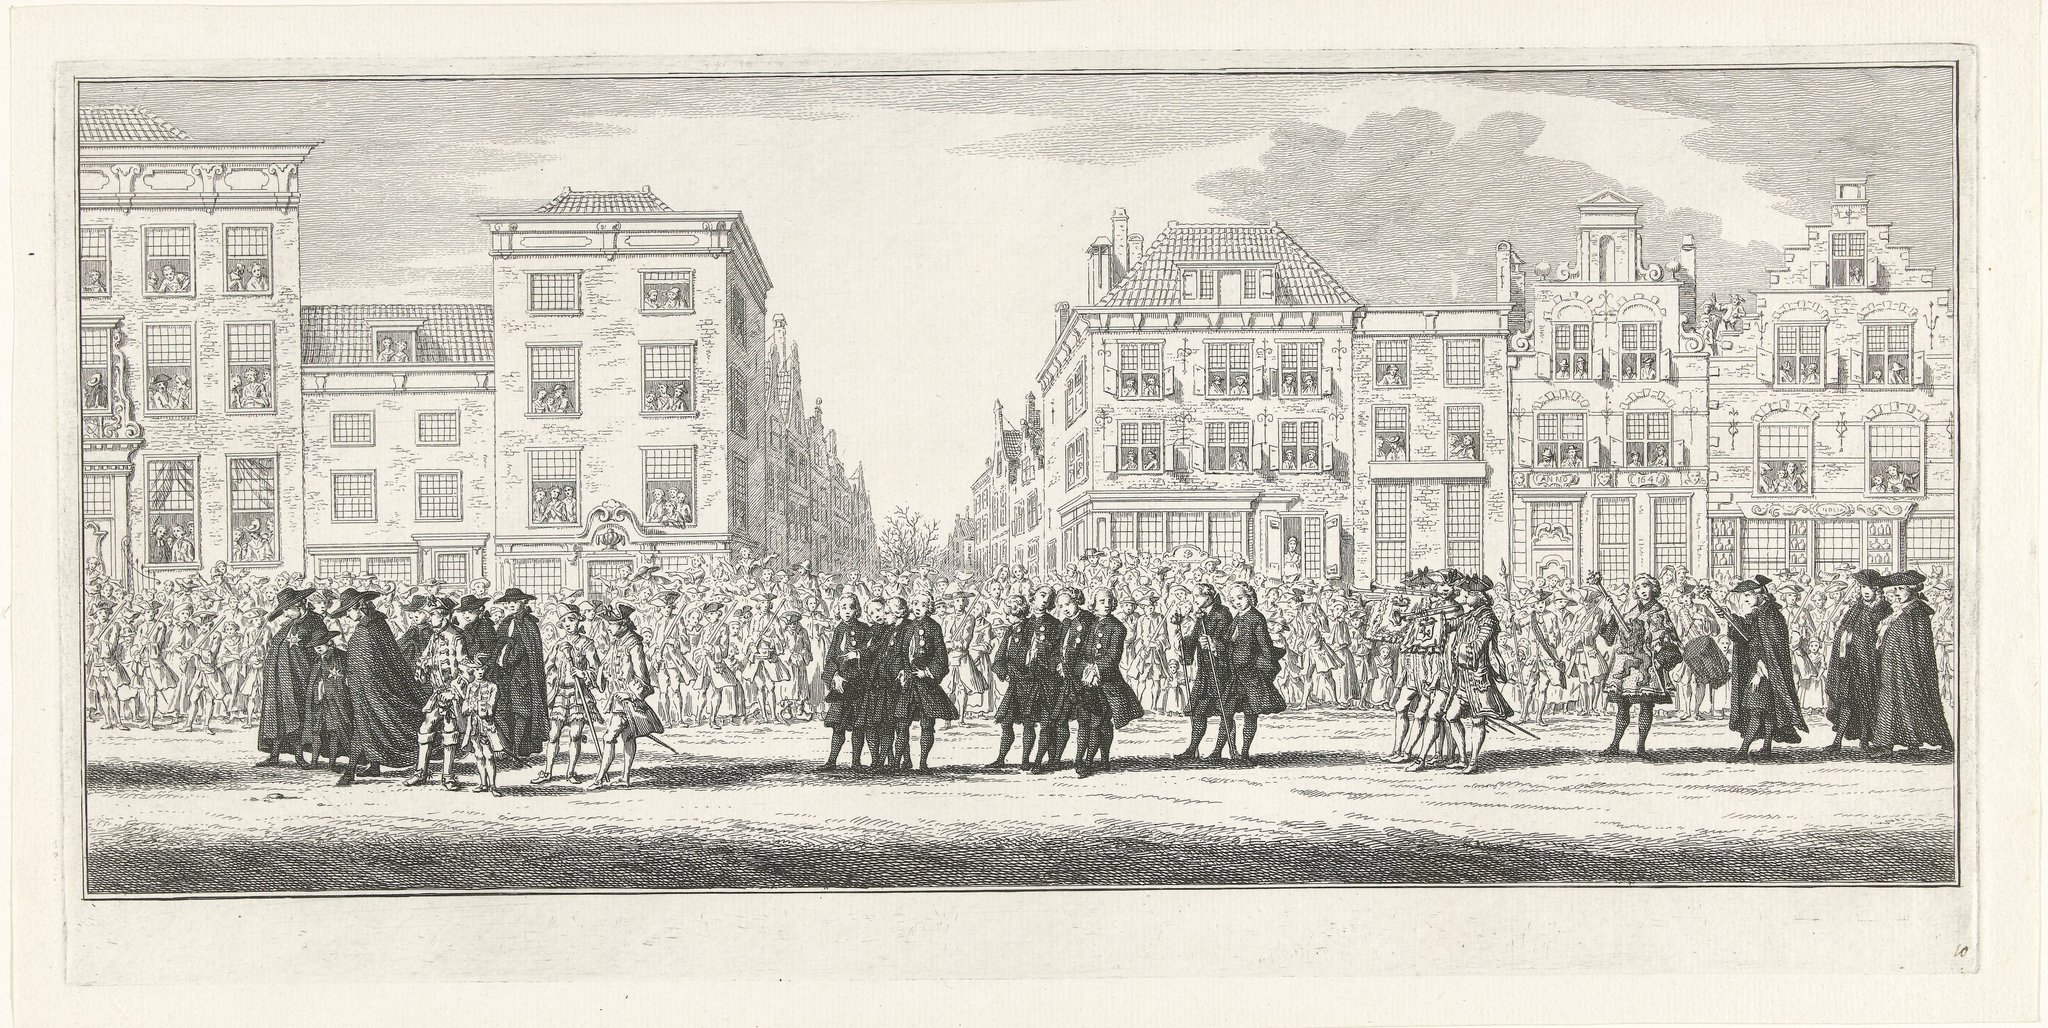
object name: print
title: Lijkstoet van prinses Anna van Hannover te Delft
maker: simon fokke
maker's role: draughtsman, print maker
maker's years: 1712-1784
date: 1759-1761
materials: paper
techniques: etching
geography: amsterdam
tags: william v (prince of orange), the hague, anna van hannover, cortege, funeral procession, delft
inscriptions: serial number: ‘10’, collector's mark: Lugt 2228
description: Prins Willem V met familie gevolgd door personeel van de Staten-Generaal. Onderdeel van een serie van 16 platen in etsdruk van de lijkstatie van de op 23 februari 1759 te Delft begraven prinses Anna van Hannover.